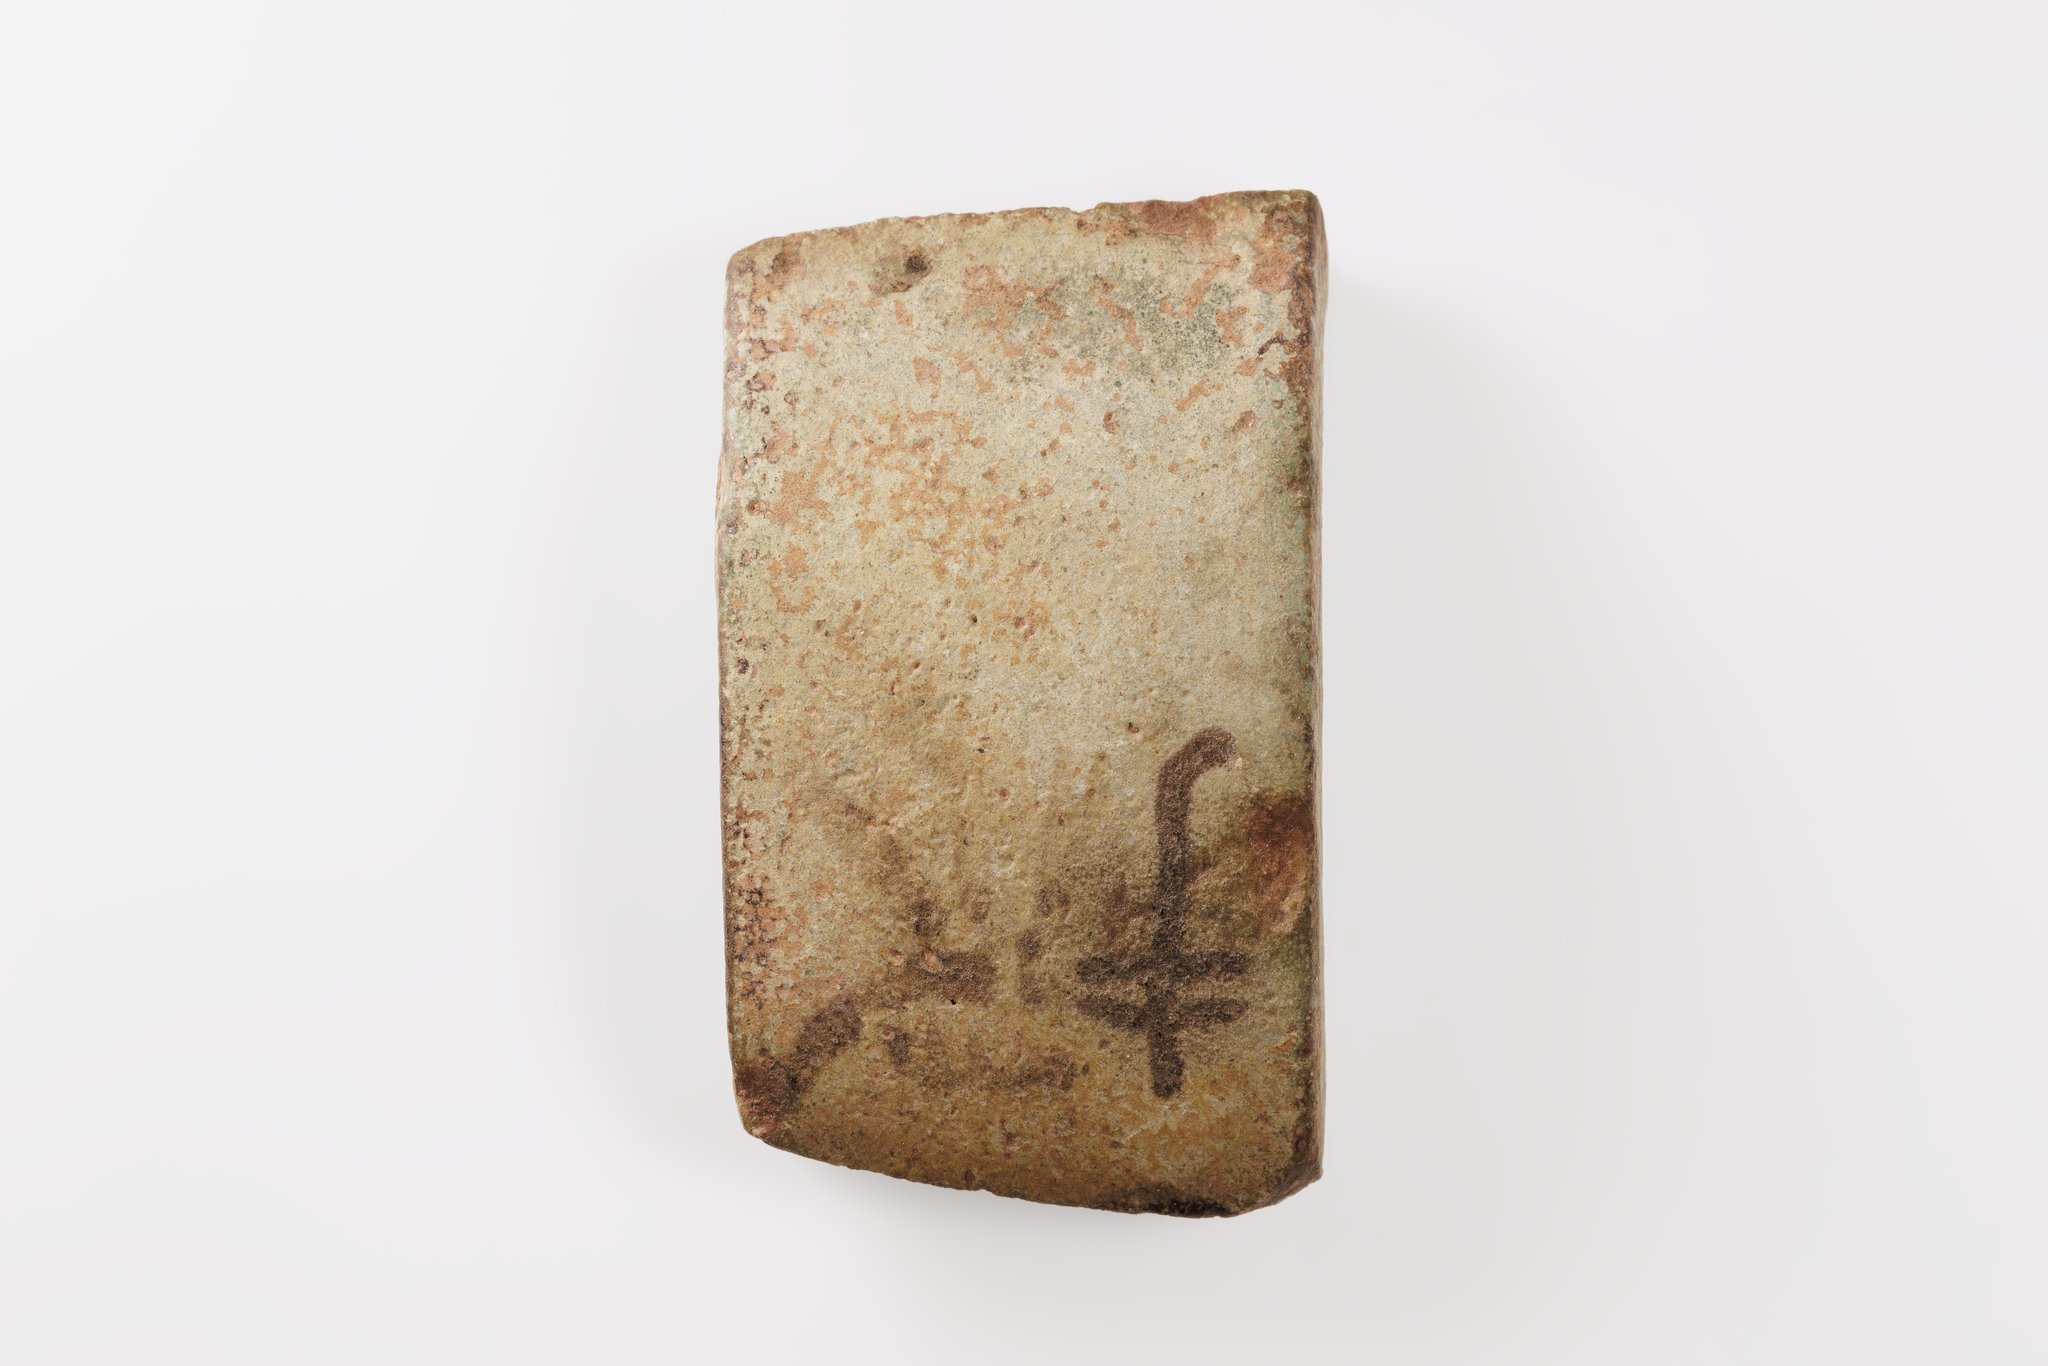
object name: votive bracelet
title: Fragment of a votive bracelet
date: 1295-1070 BCE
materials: faience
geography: egypt